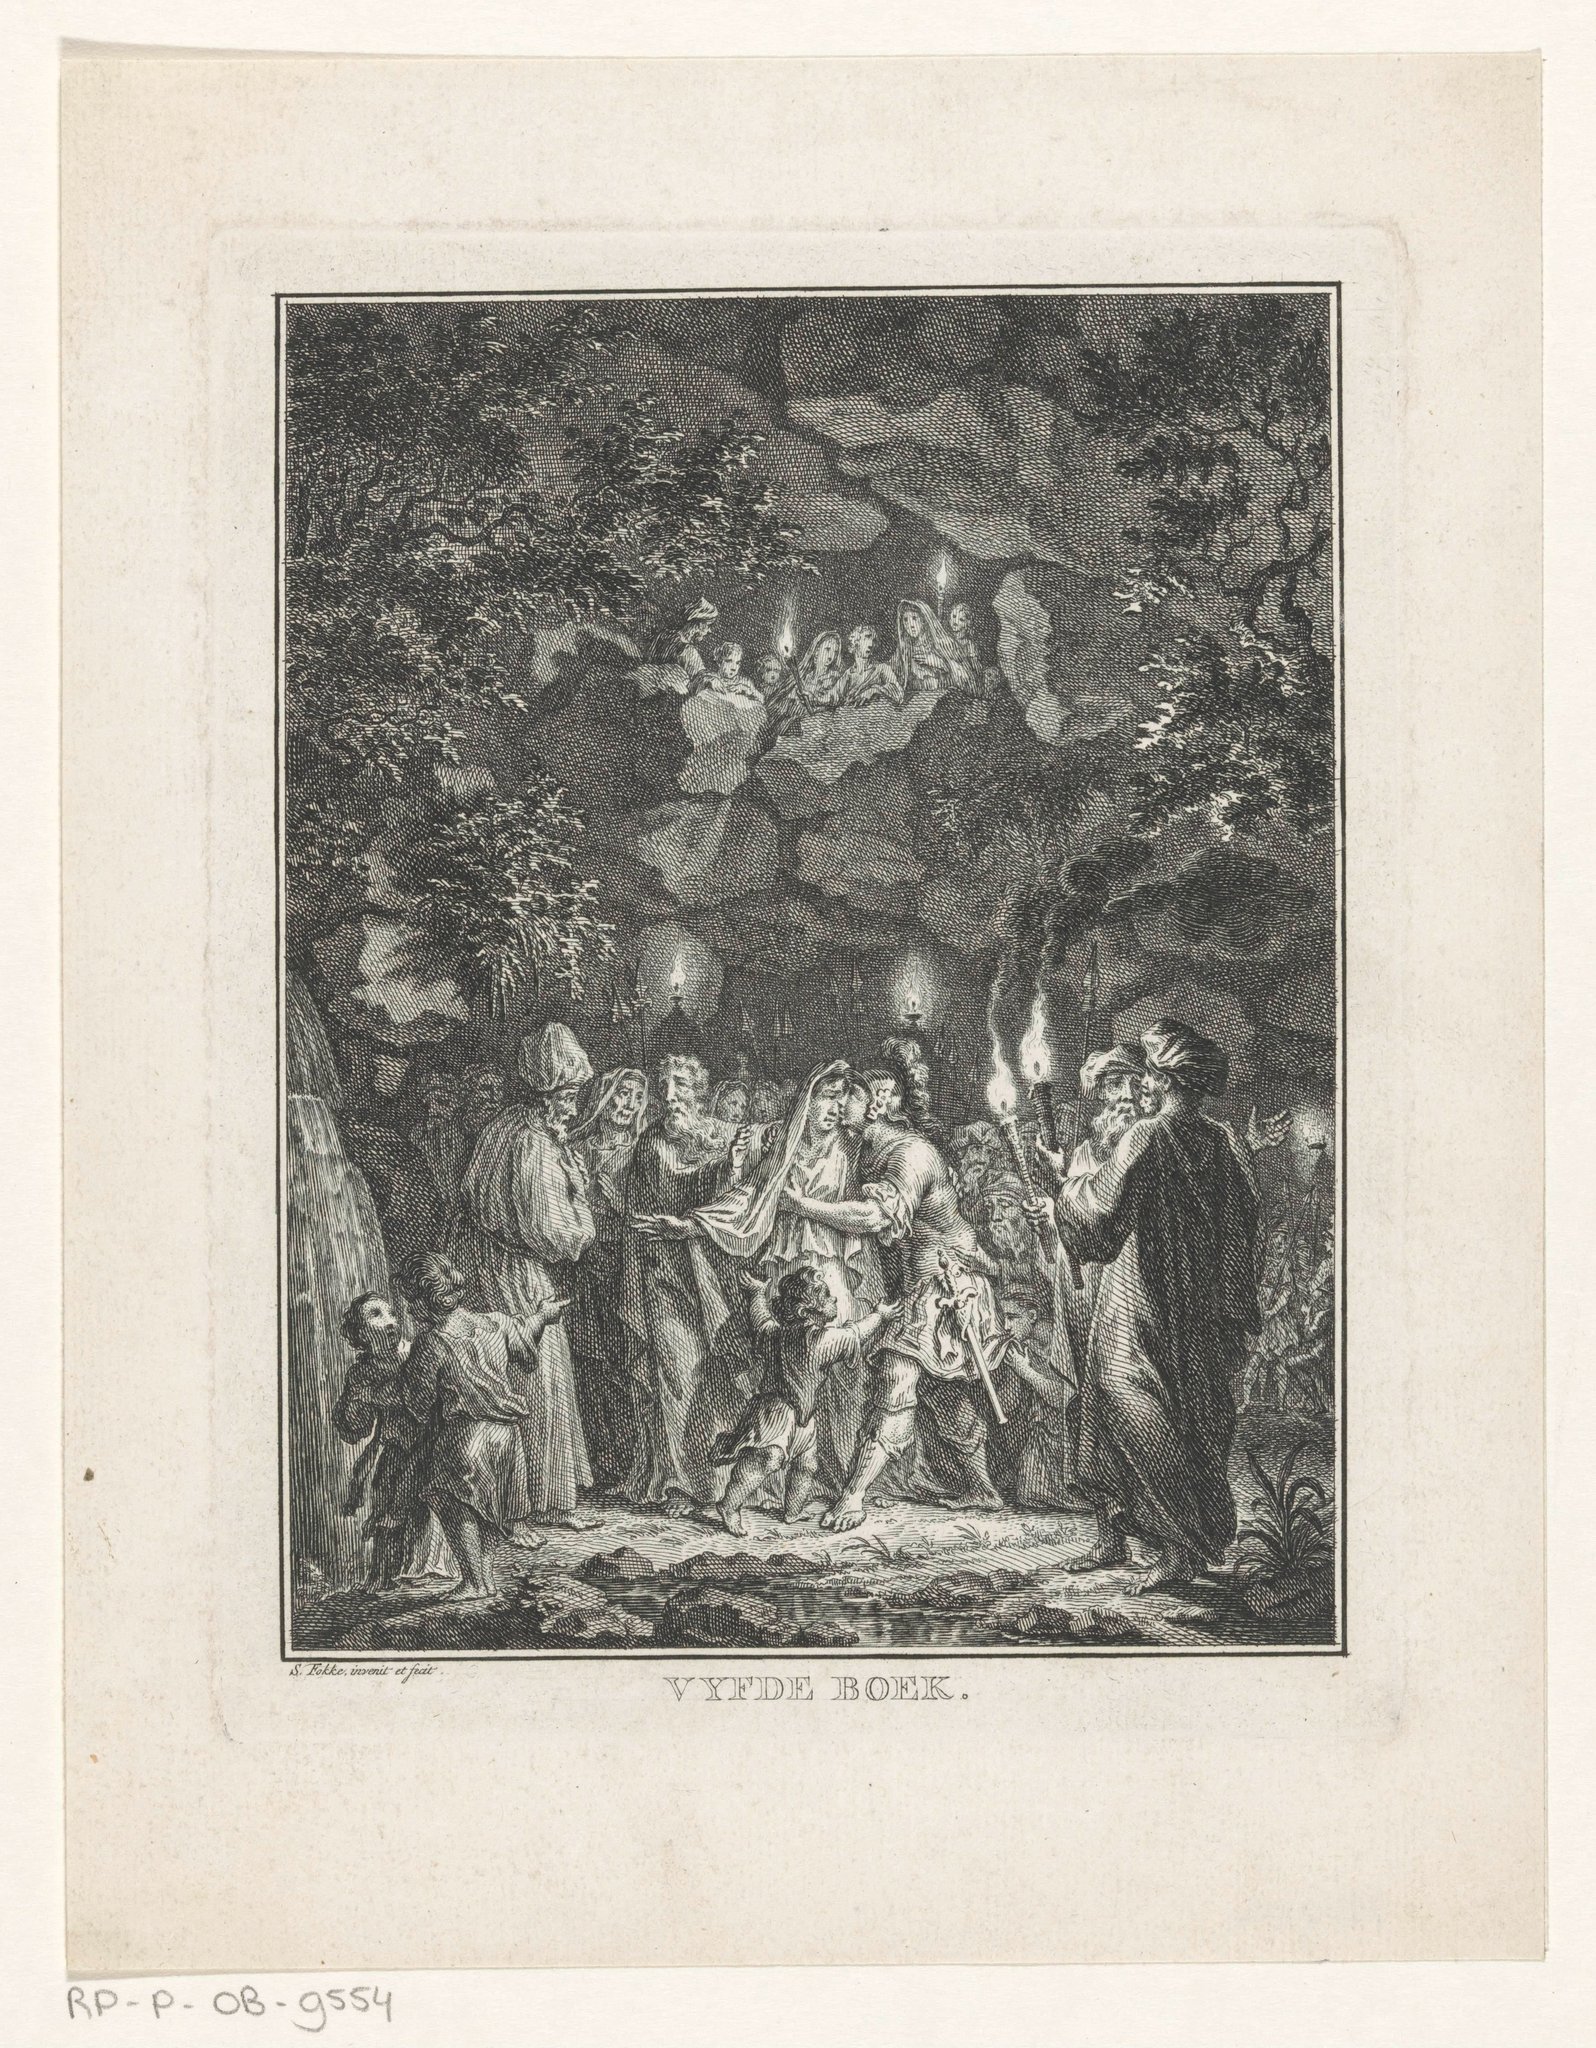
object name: book illustration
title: David neemt afscheid van Michal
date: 1766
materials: paper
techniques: etching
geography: amsterdam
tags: david's flight from saul after his marriage with michal (1 samuel 19)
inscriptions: collector's mark: Lugt 2228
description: Bij fakkellicht en omringd door omstanders neemt David in legerkleding afscheid van zijn treurende eerste vrouw Michal.